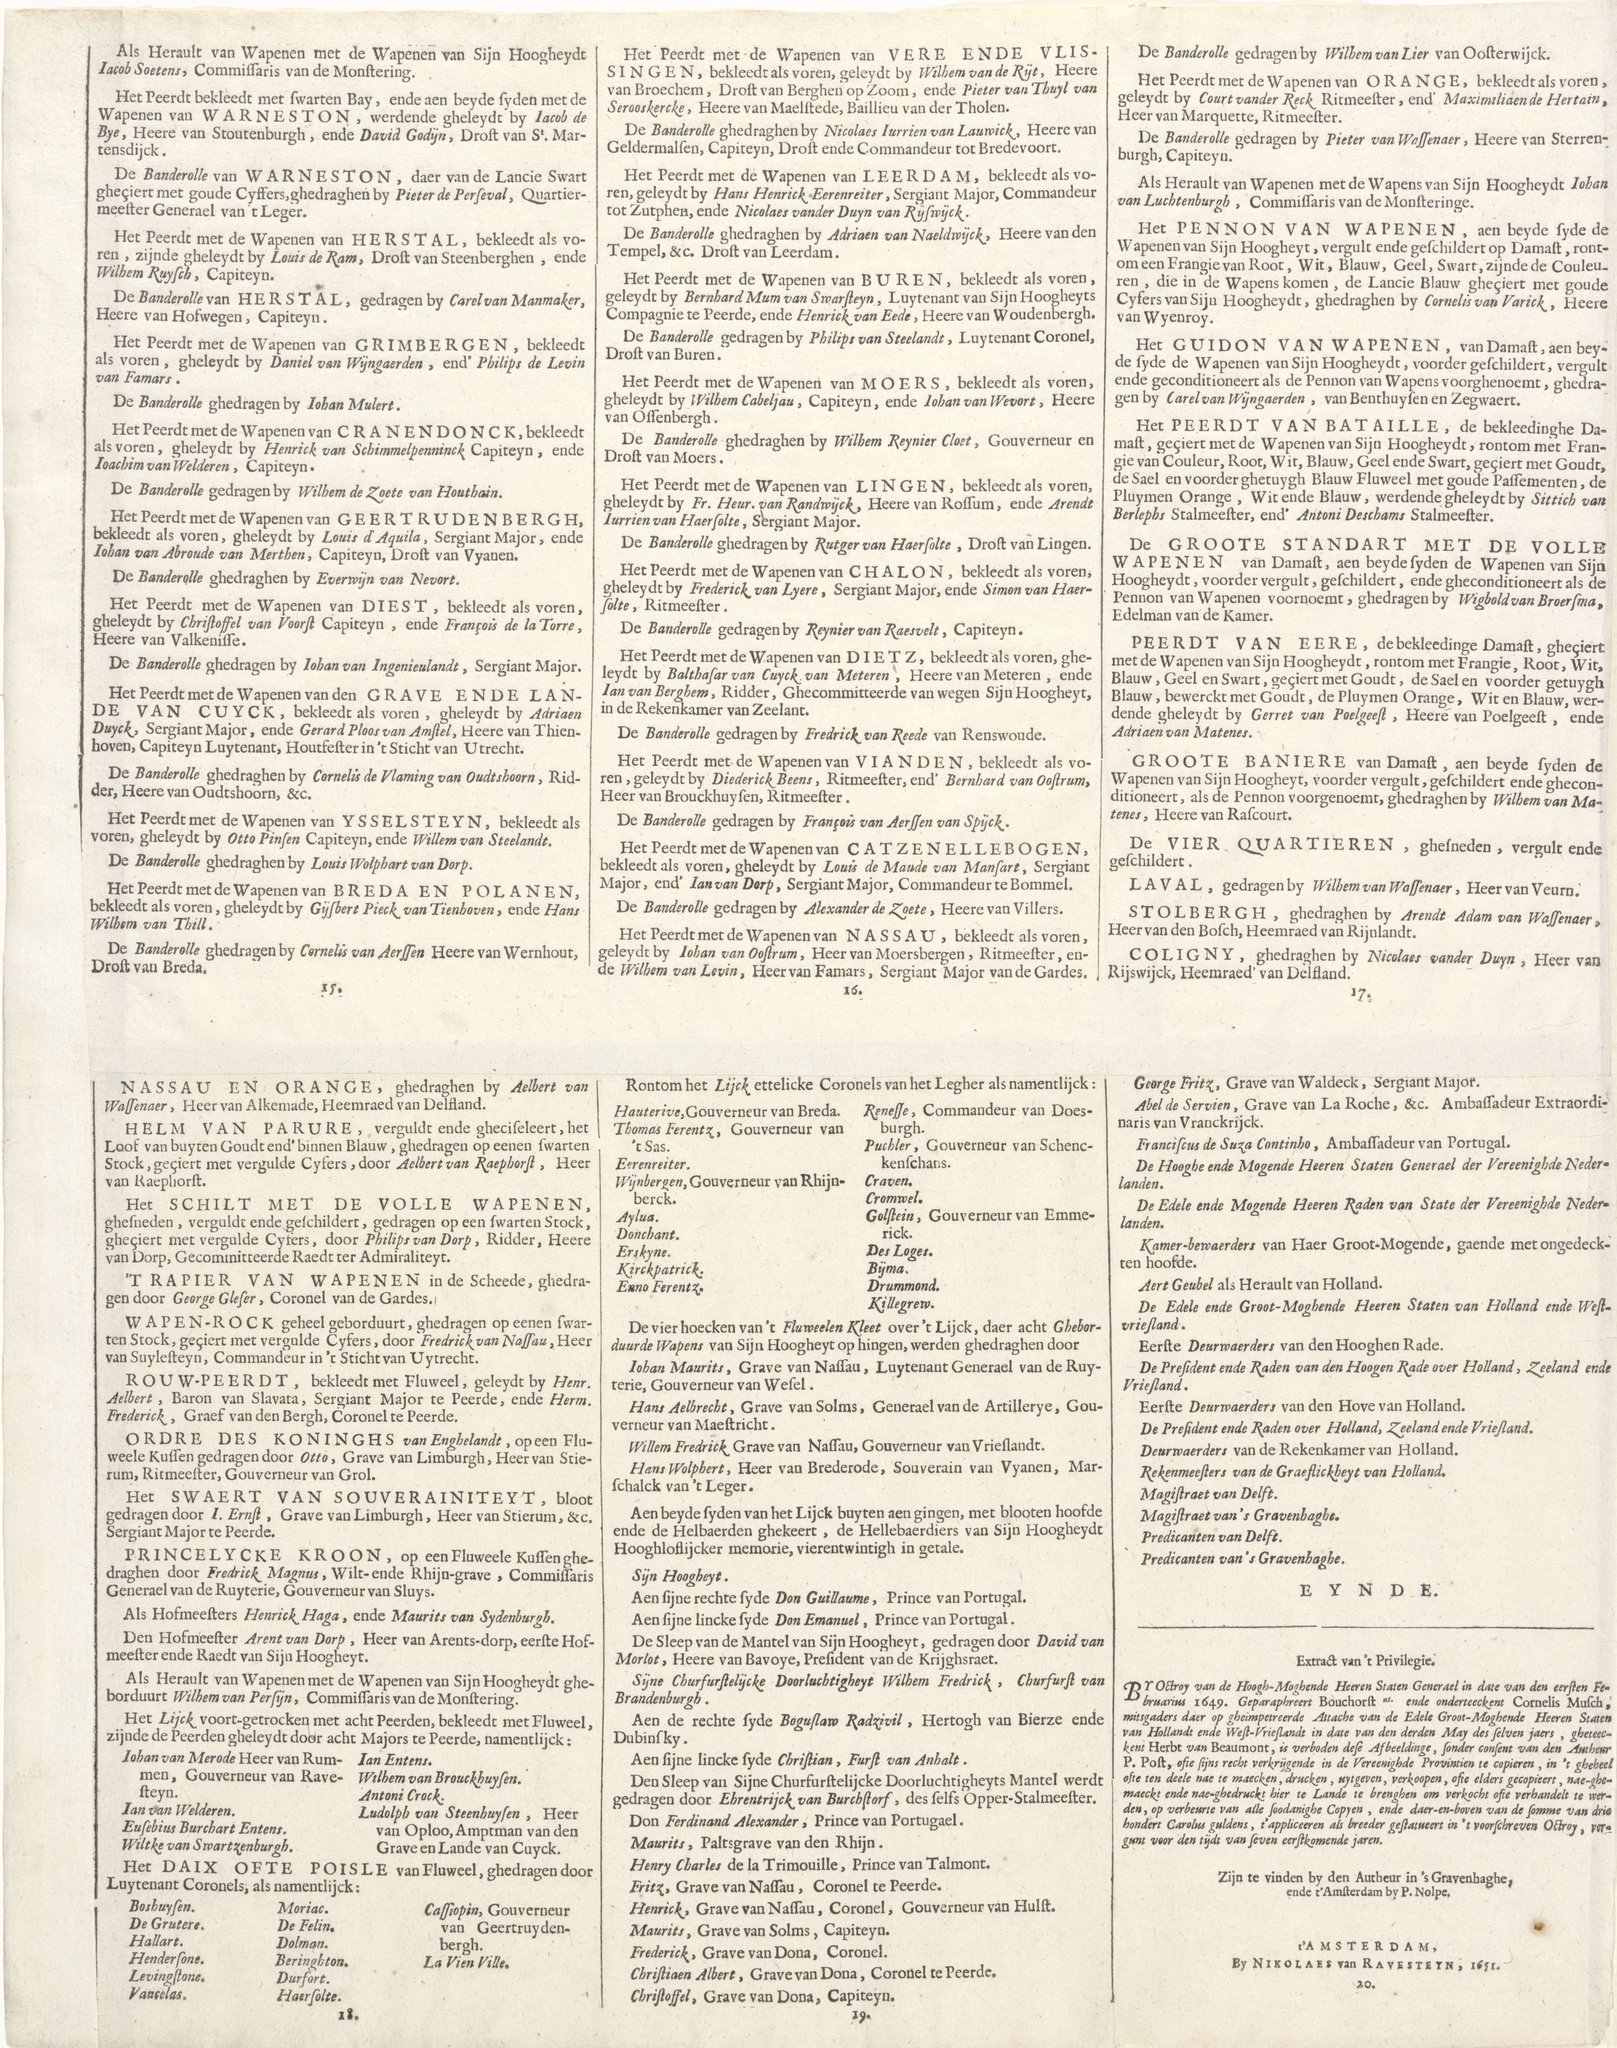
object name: text sheet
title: Begraeffenisse van Syne Hoogheyt Frederick Henrick, by der Gratien Gods Prince van Orange, Grave van Nassau &c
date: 1651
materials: paper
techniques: letterpress printing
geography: the hague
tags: delft, the hague, frederick henry (prince of orange)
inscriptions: collector's mark: Lugt 2228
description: Blad samengesteld uit twee aan elkaar geplakte bladen met de zes tekstbladen genummerd 15-20, behorend bij de prentserie van de begrafenisstoet van stadhouder Frederik Hendrik te 's-Gravenhage op 10 mei 1647. Onderdeel van een serie van 30 platen en 20 tekstbladen, bedoeld om aan elkaar geplakt te worden.